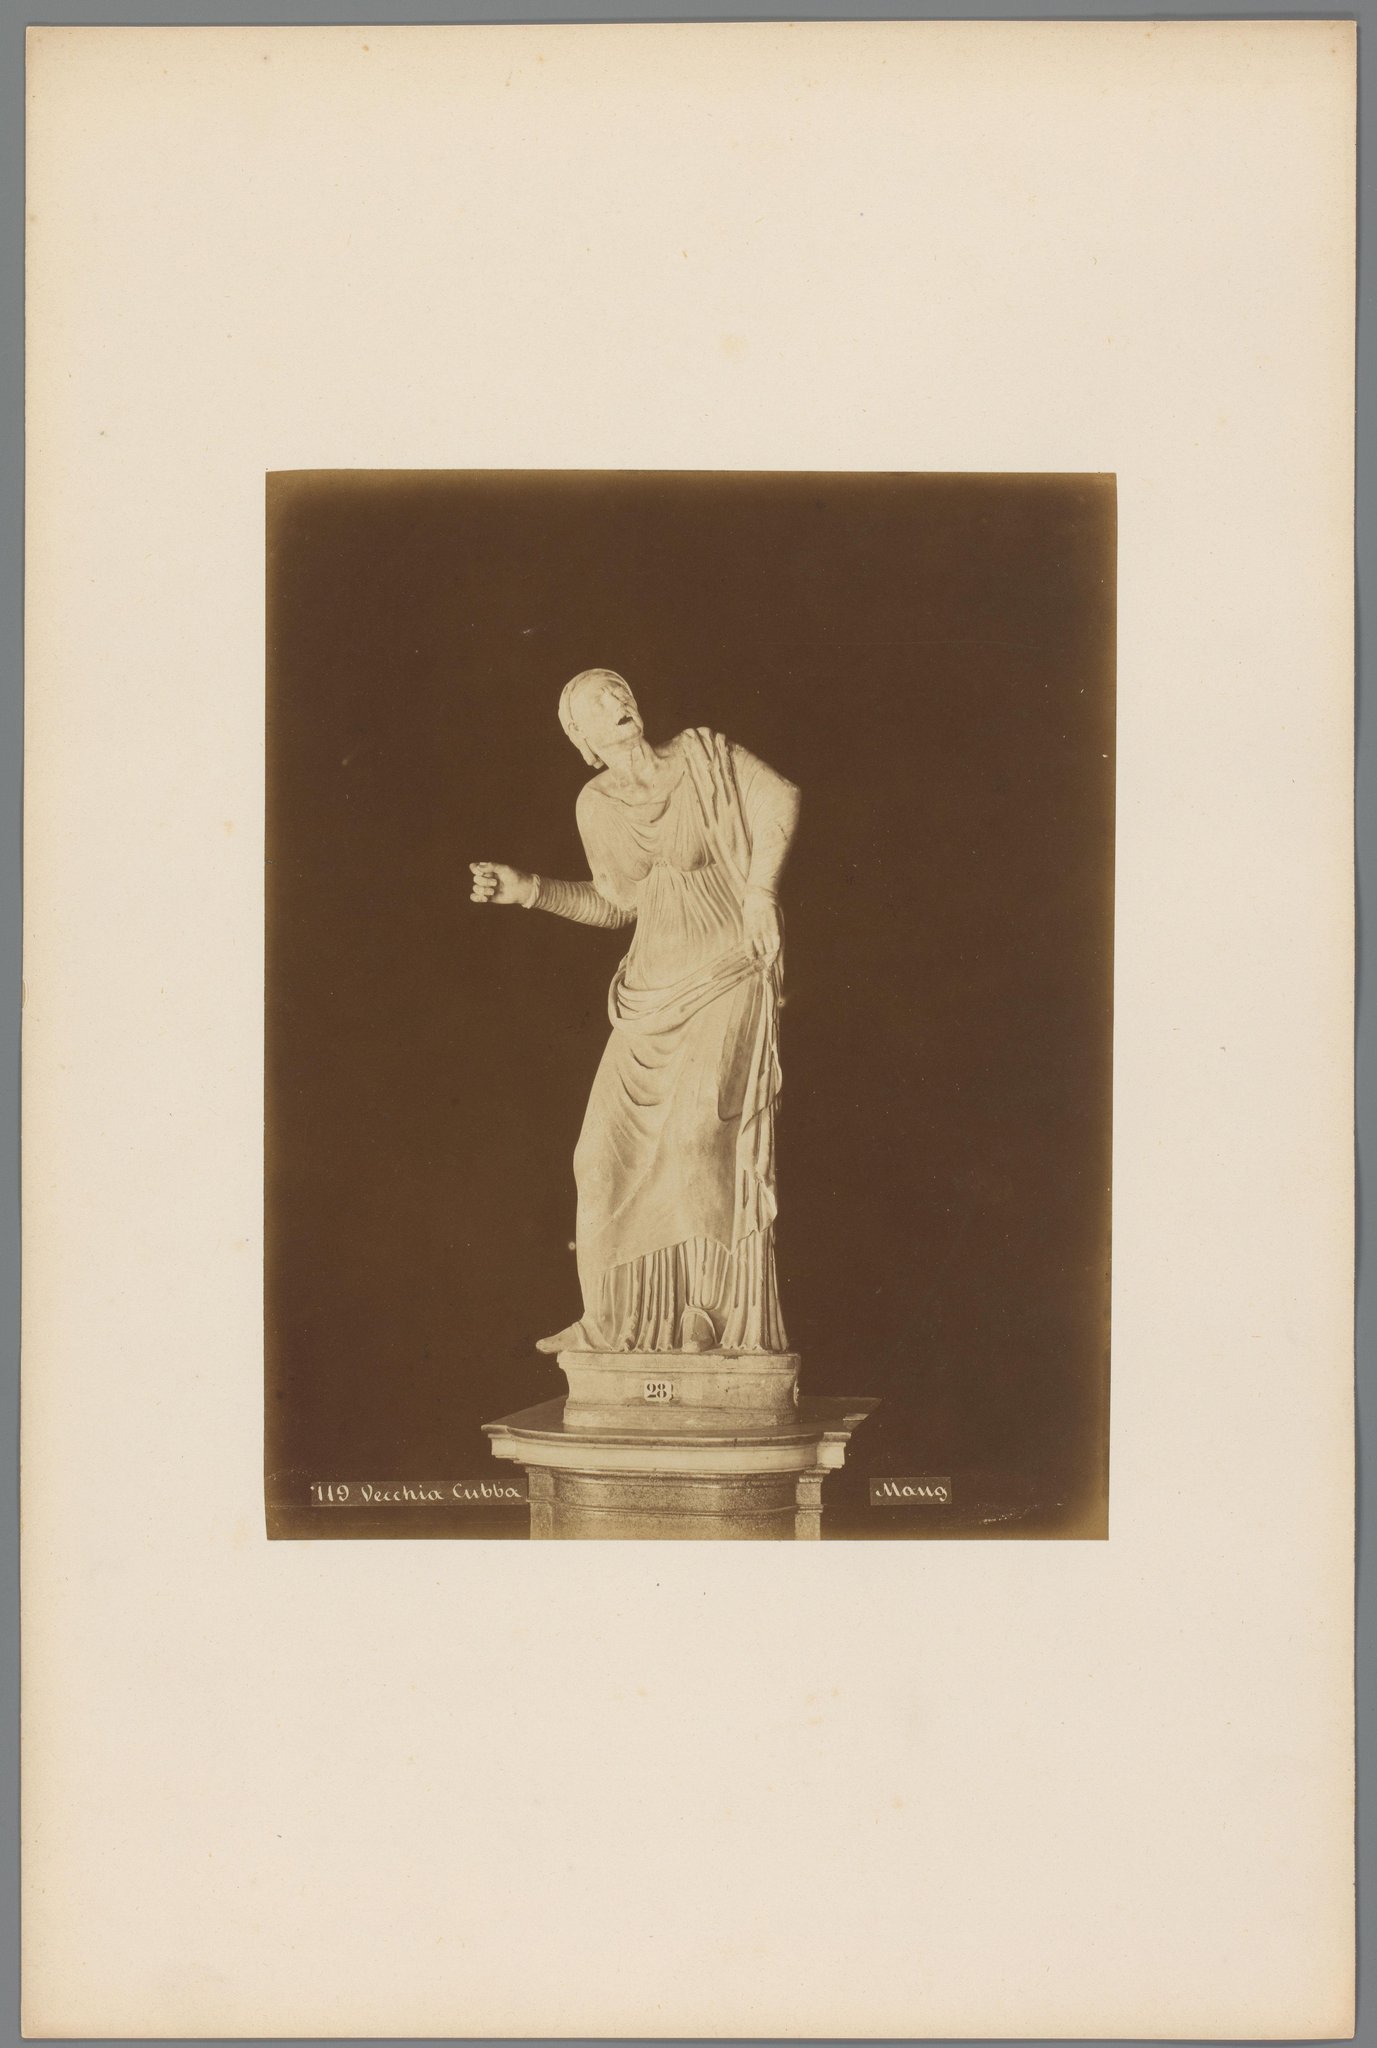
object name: photograph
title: Sculptuur van een oude vrouw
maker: michèle mang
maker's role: fotograaf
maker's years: 1840-1909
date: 1863-1887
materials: cardboard, paper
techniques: albumen print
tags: old woman, piece of sculpture, reproduction of a piece of sculpture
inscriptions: number: ‘119’